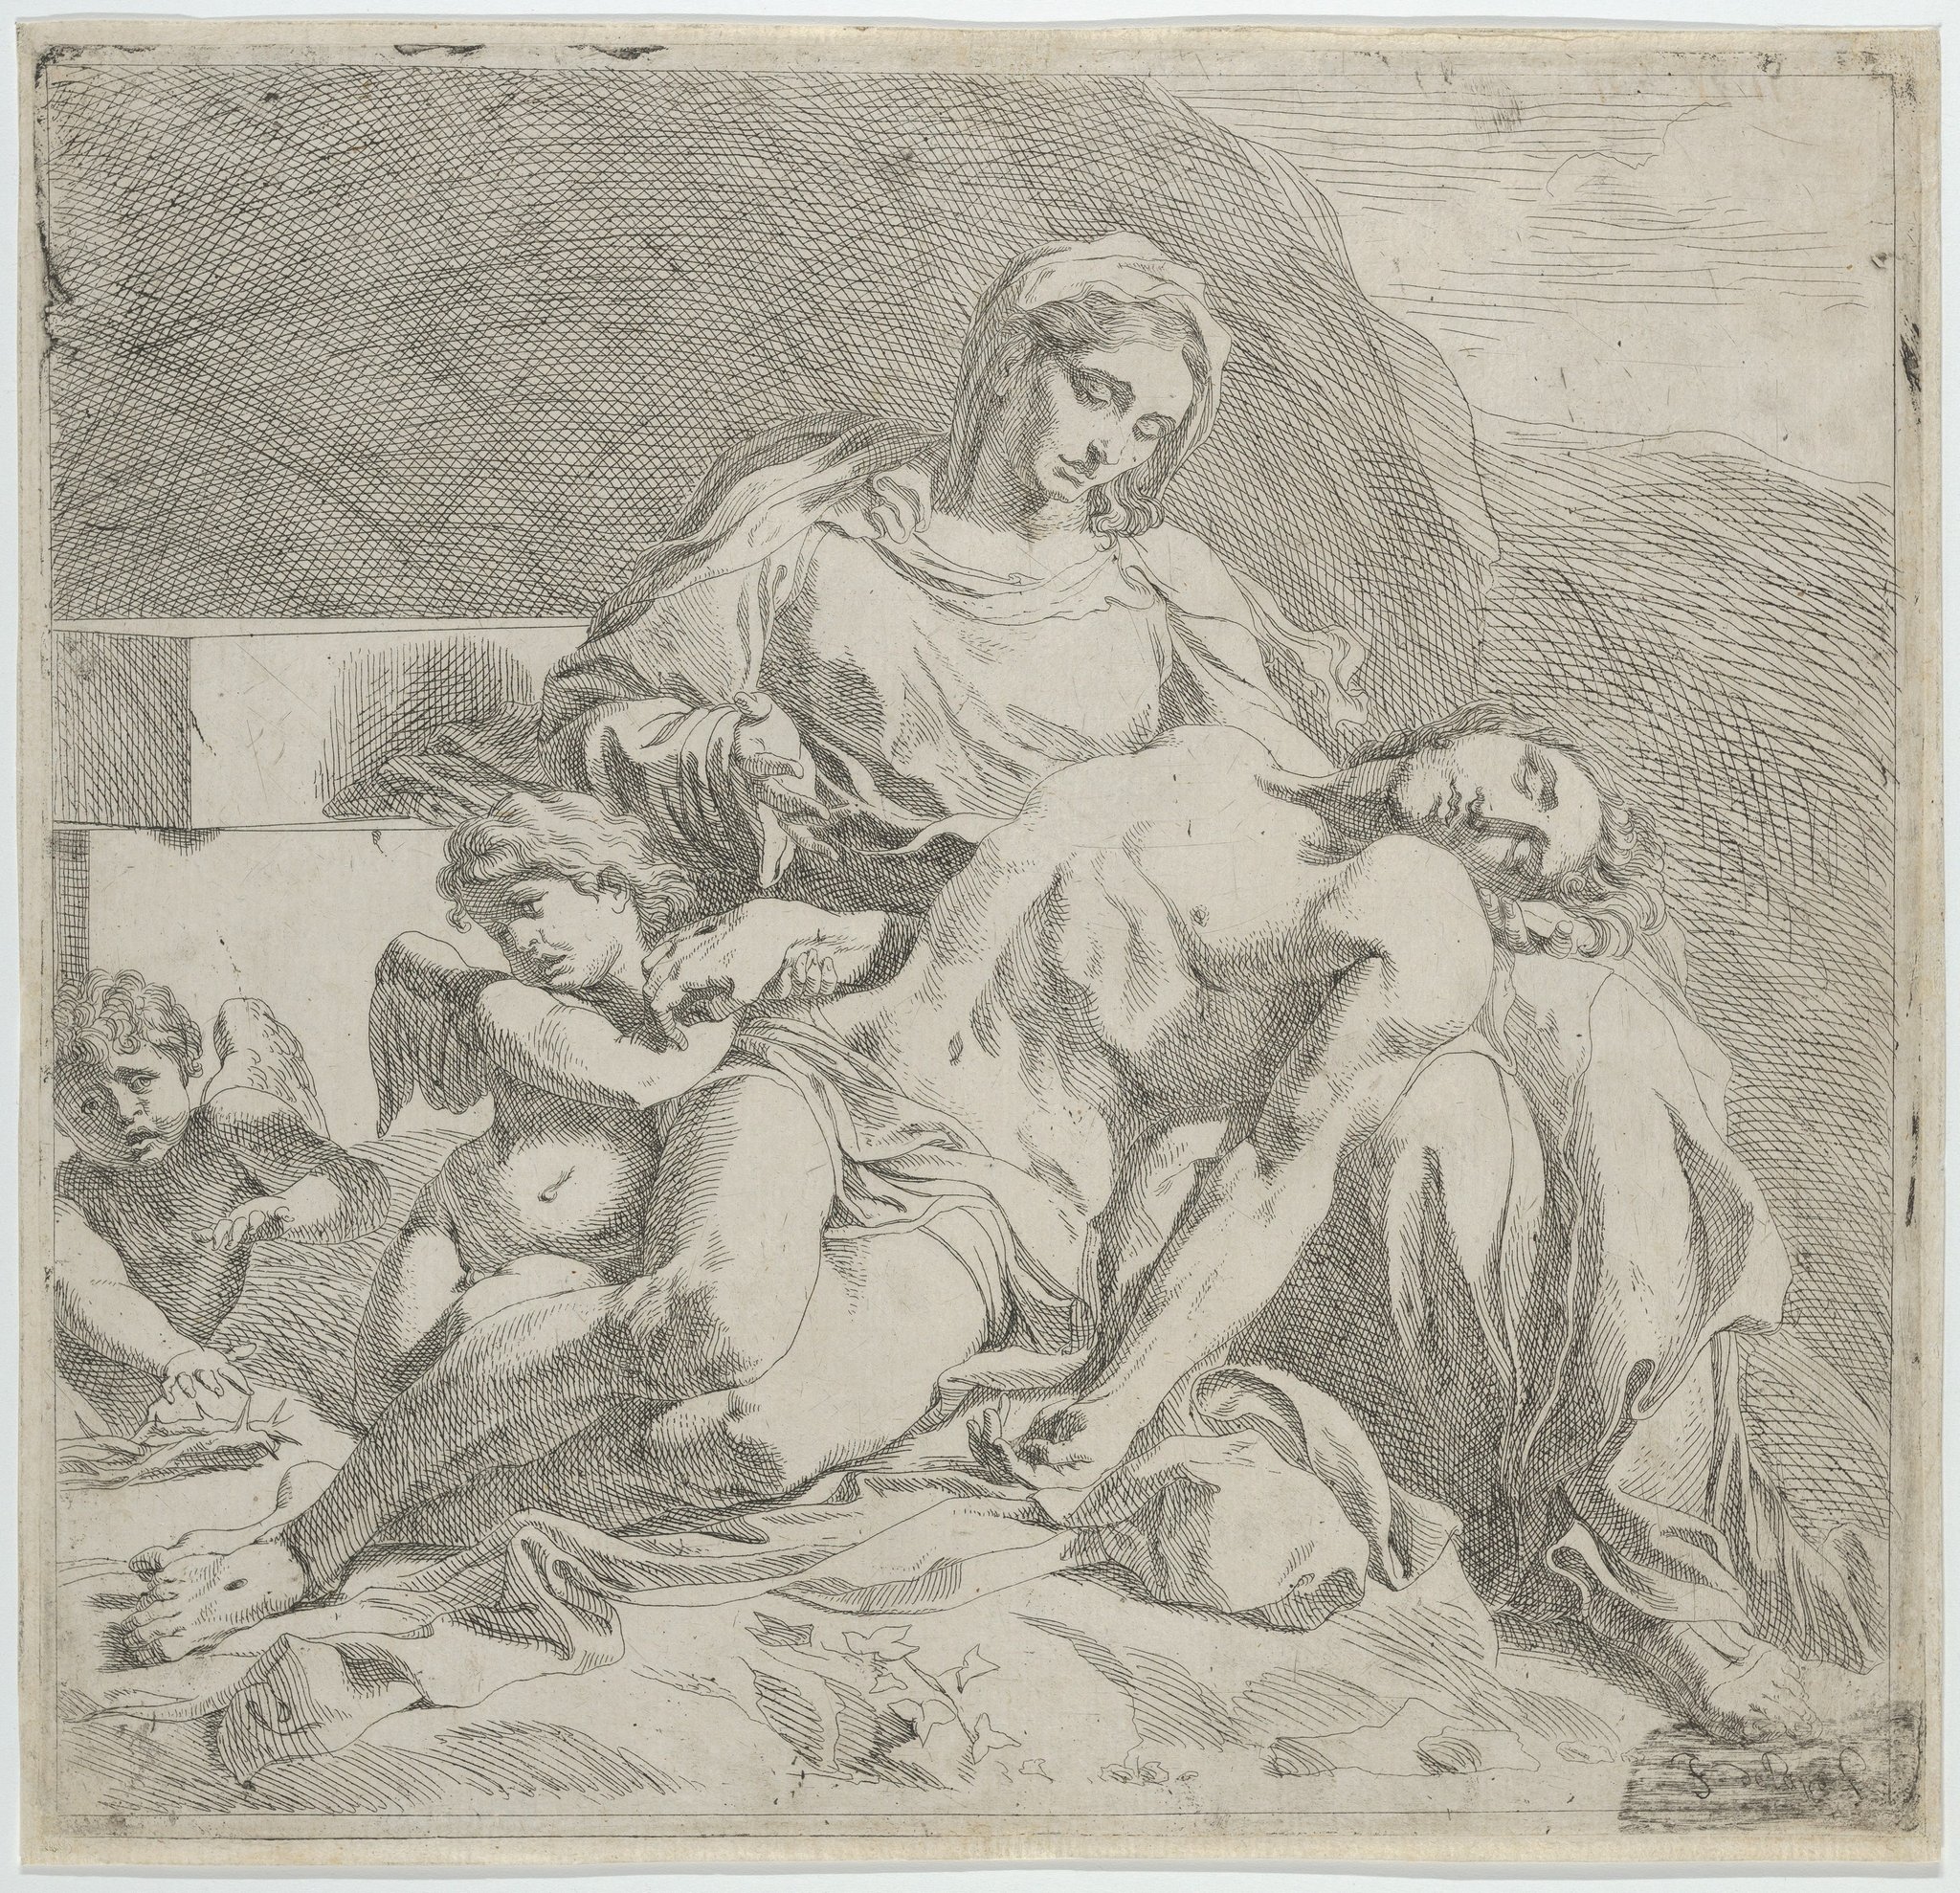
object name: print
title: Pietà, the dead Christ supported by the Virgin, putti at the left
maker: joost de pape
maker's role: artist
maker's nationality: flemish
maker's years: 1618-1646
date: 1633-1646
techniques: etching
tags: angels,christ,virgin mary